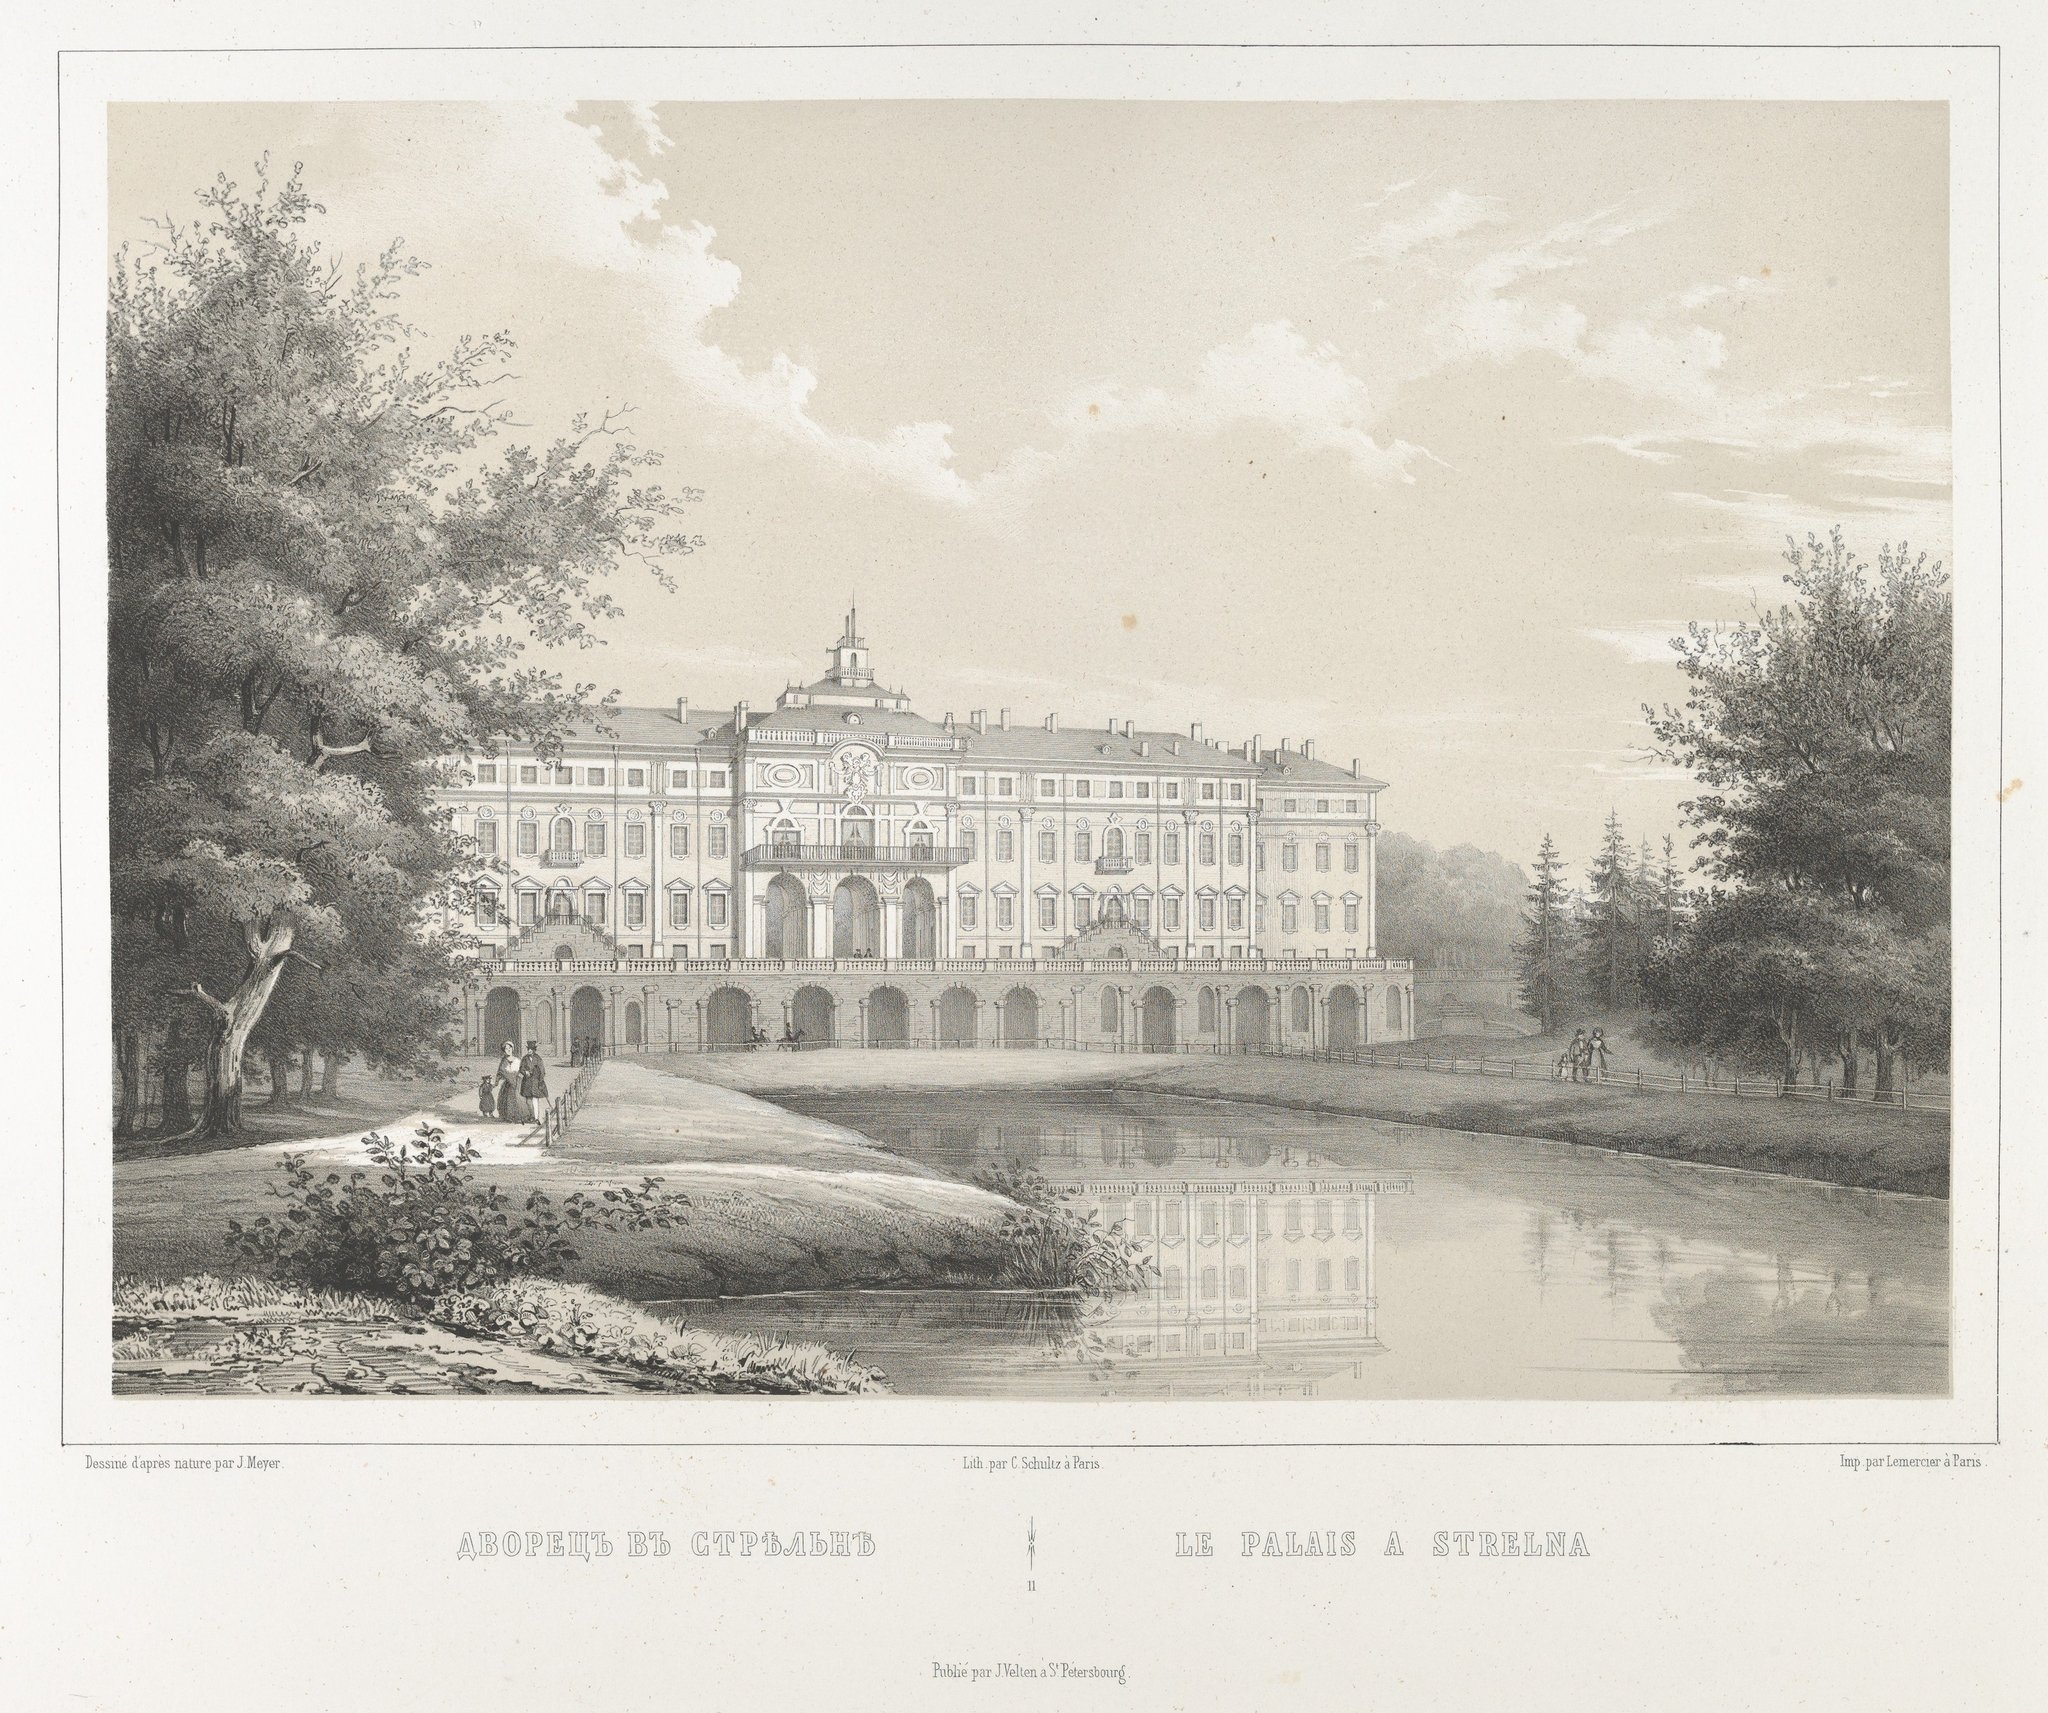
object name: print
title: Le Palais à Strelna, from "Vues pittoresques des palais & jardins impériaux aux environs de St. Petersbourg"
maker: j. meyer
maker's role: artist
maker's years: 1800-1900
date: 1850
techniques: lithograph, printing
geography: russia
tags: palaces,gardens